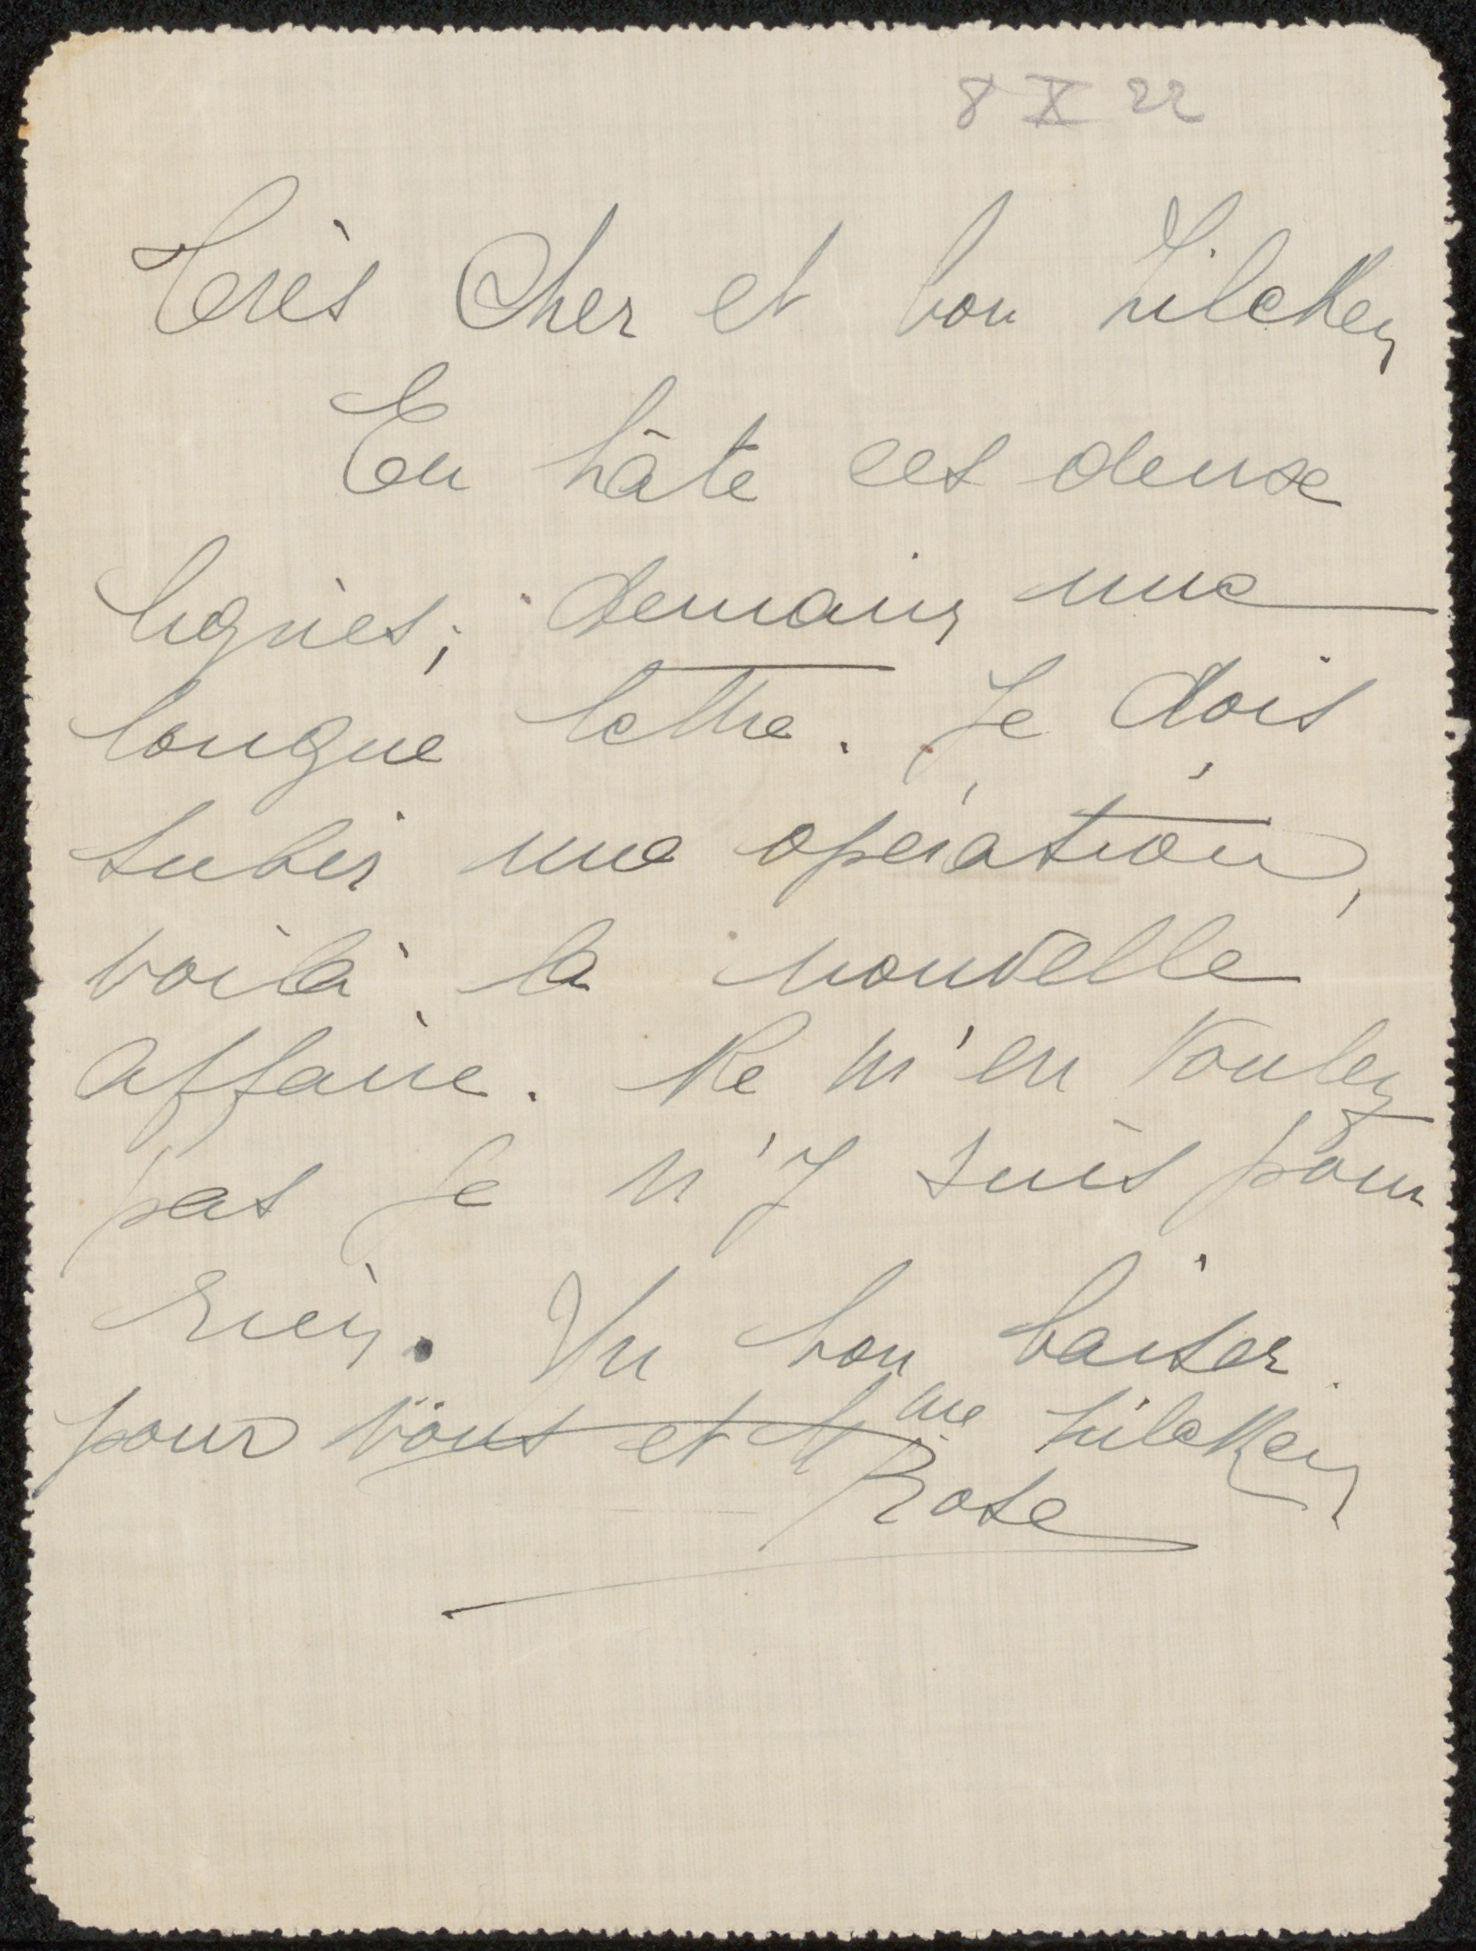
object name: letter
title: Brief aan Philip Zilcken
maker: rose imel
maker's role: draughtsman, painter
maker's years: 1901-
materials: ink, paper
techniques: pen, writing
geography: paris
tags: the hague, philip zilcken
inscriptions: collector's mark: ‘RPK’